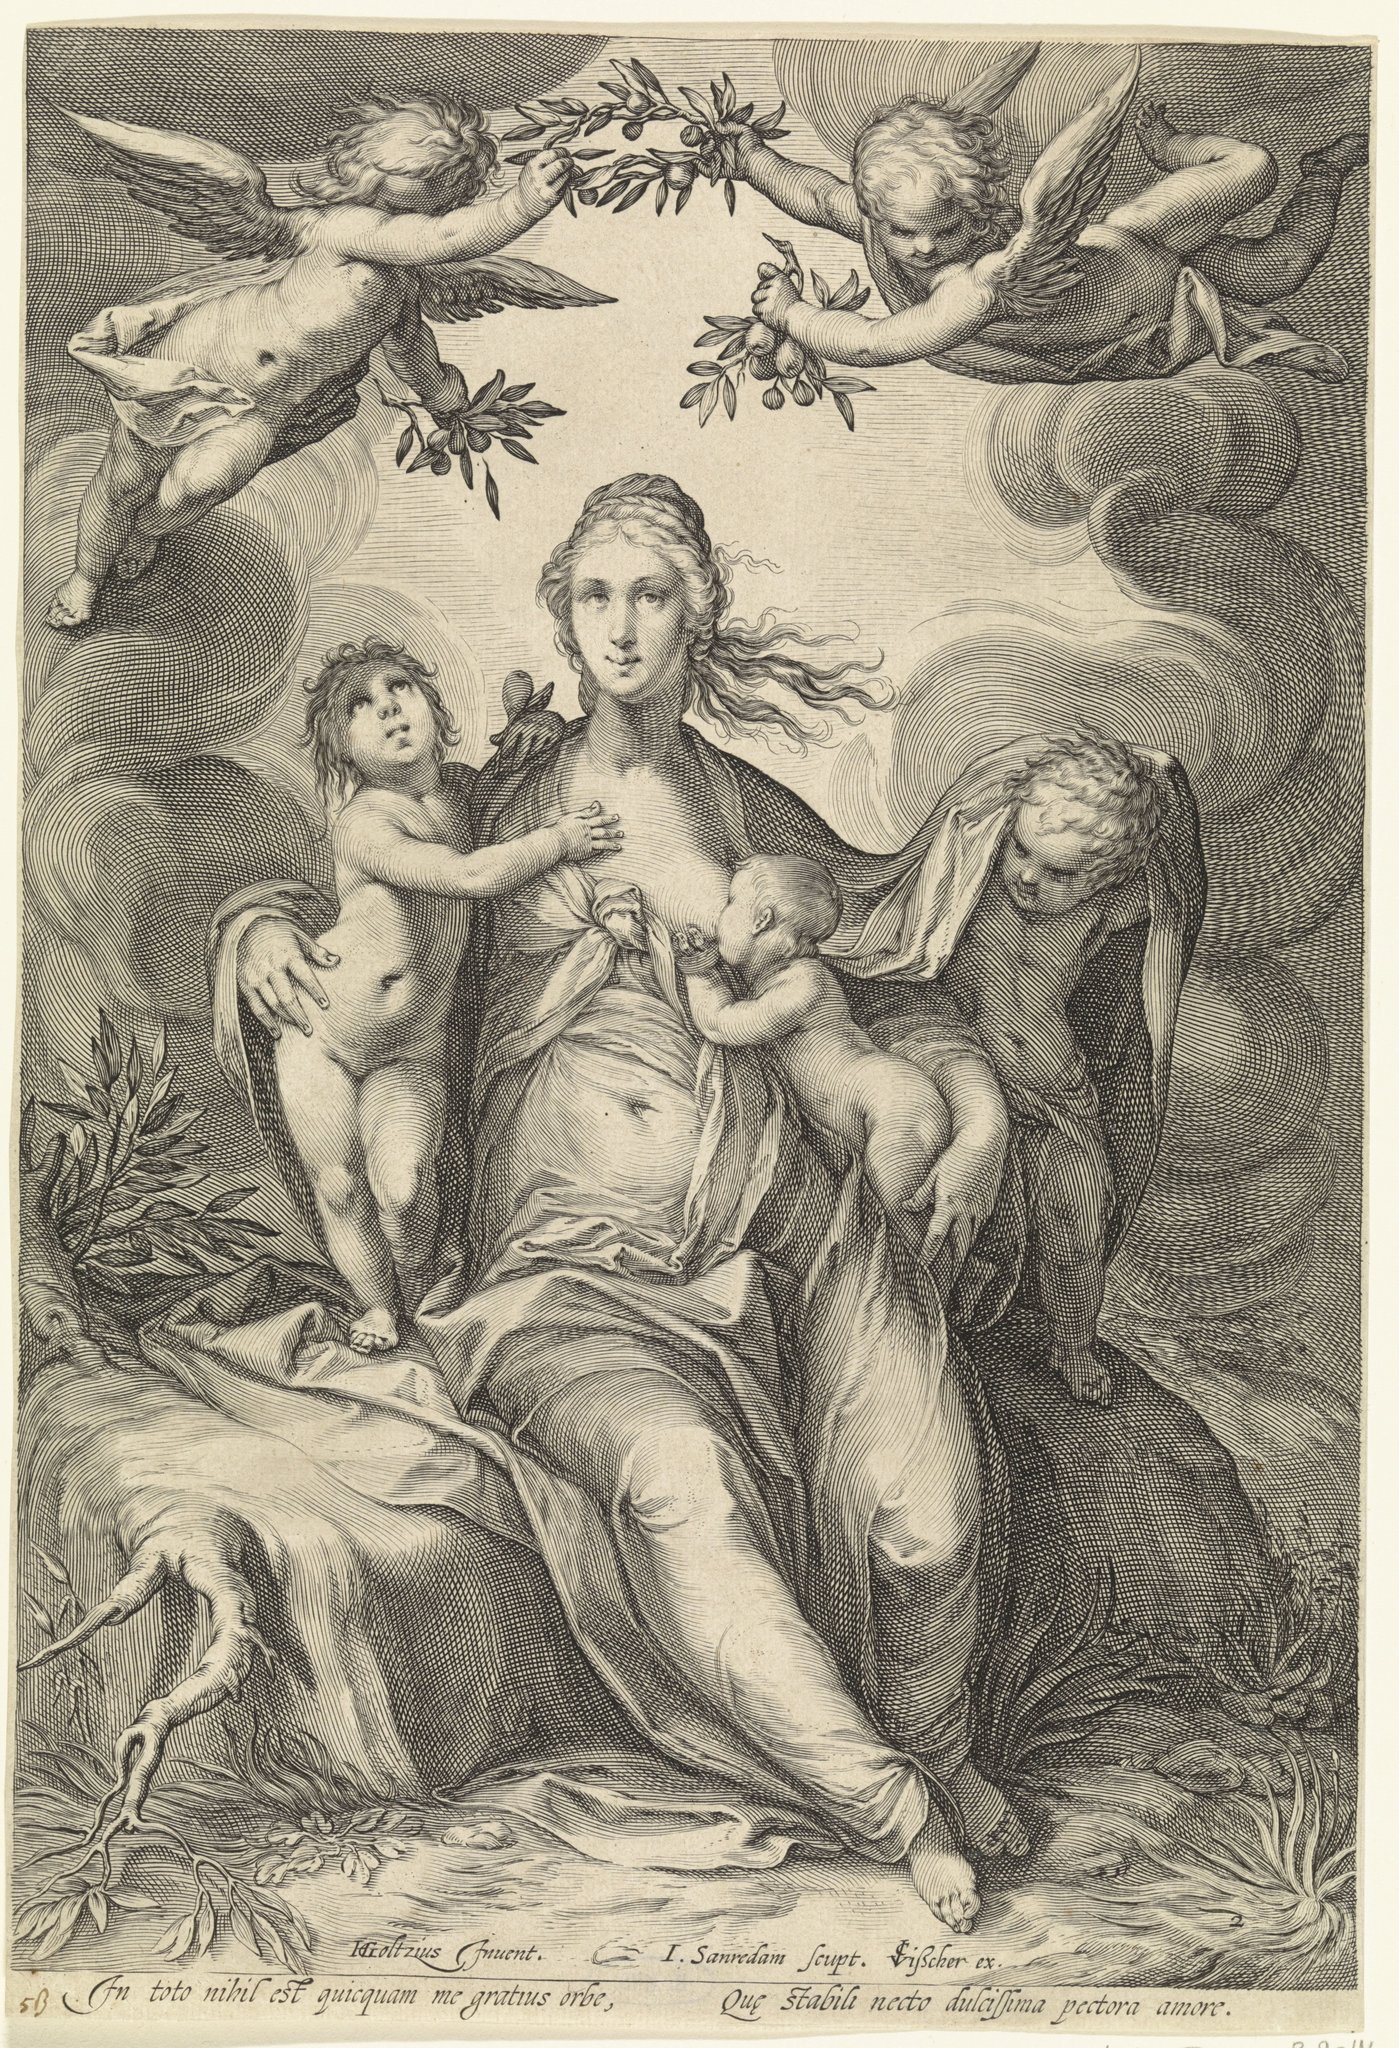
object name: print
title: Drie goddelijke deugden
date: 1601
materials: paper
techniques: engraving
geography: amsterdam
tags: charity, 'caritas'; 'carità' (ripa) ~ one of the three theological virtues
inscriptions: collector's mark: Lugt 240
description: De vrouwelijke personificatie van de Liefde, een van de drie goddelijke deugden, zoogt een kind en omarmt twee kinderen die naast haar staan. Boven haar hoofd vliegen putti met een lauwerkrans en bloemen.